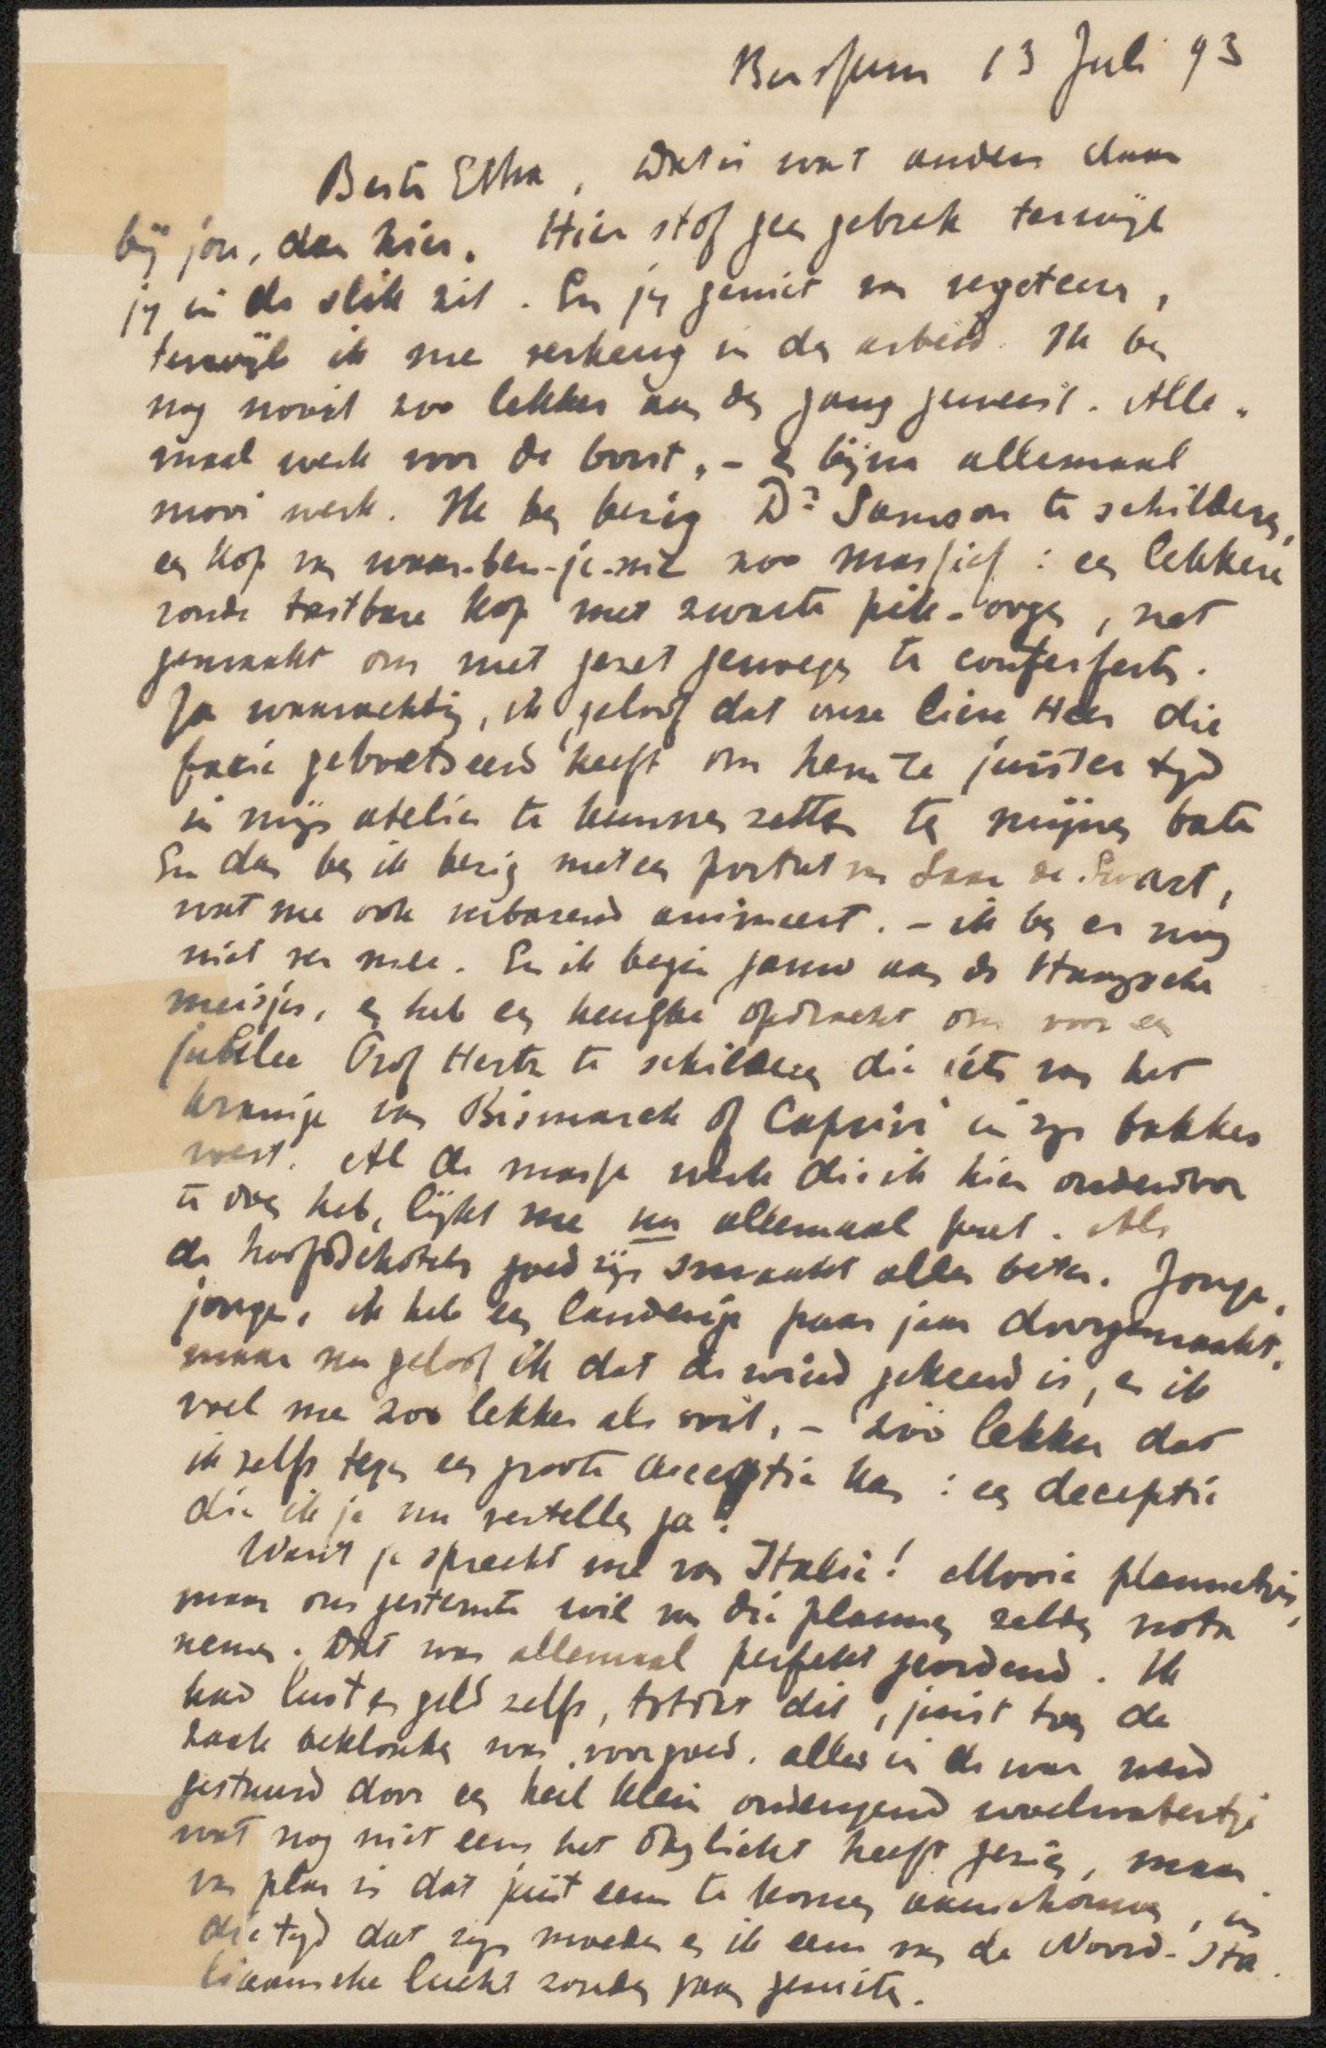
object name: letter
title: Brief aan Etha Fles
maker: jan veth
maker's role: designer, draughtsman, painter, print maker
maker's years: 1864-1925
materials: ink, paper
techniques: pen, writing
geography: bussum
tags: etha fles, arnhem, anacapri, sculptor, saar de swart, henri gilius samson, the graphic arts, historical persons (portraits and scenes from the life), italy, switzerland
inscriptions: watermark, collector's mark: ‘RPK’